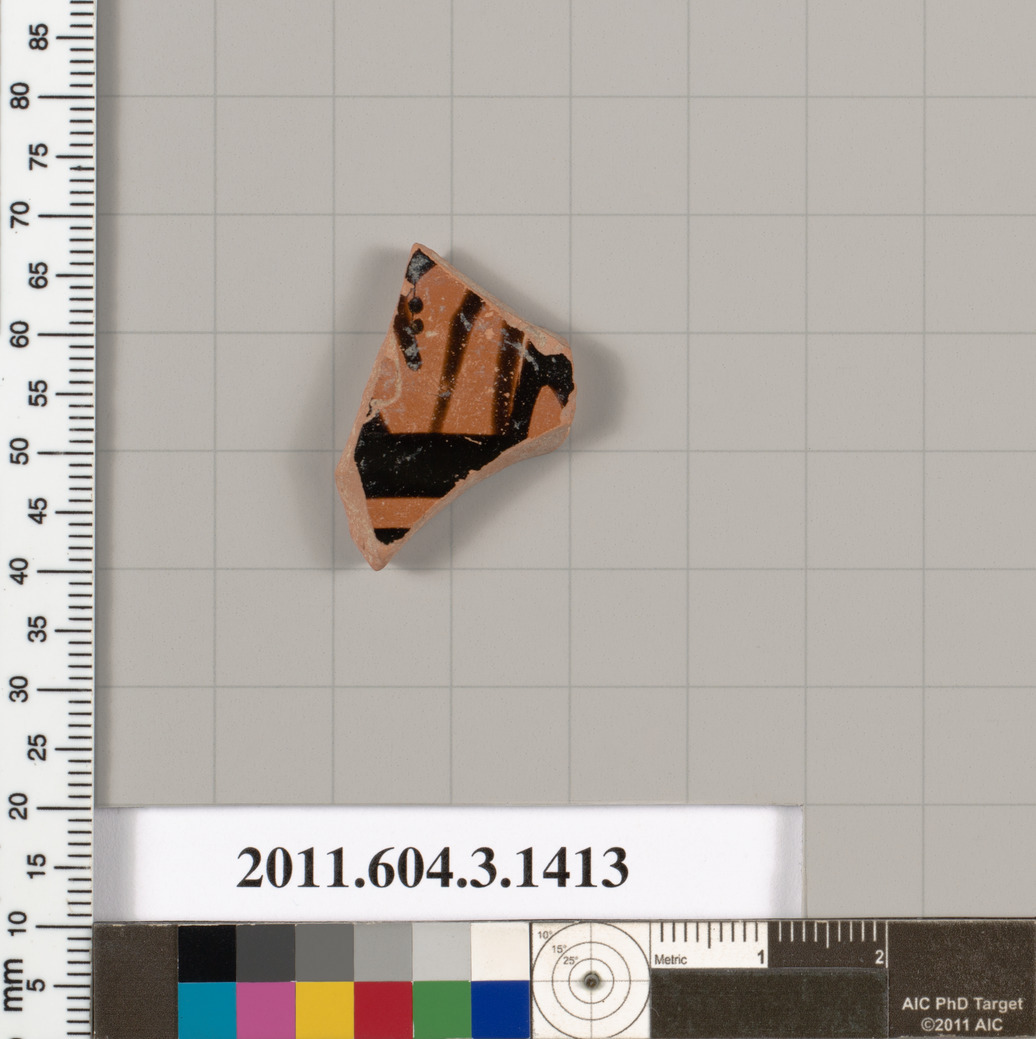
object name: skyphos fragment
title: Terracotta fragment of a skyphos (deep drinking cup)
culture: greek, attic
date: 534-468 BCE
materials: terracotta